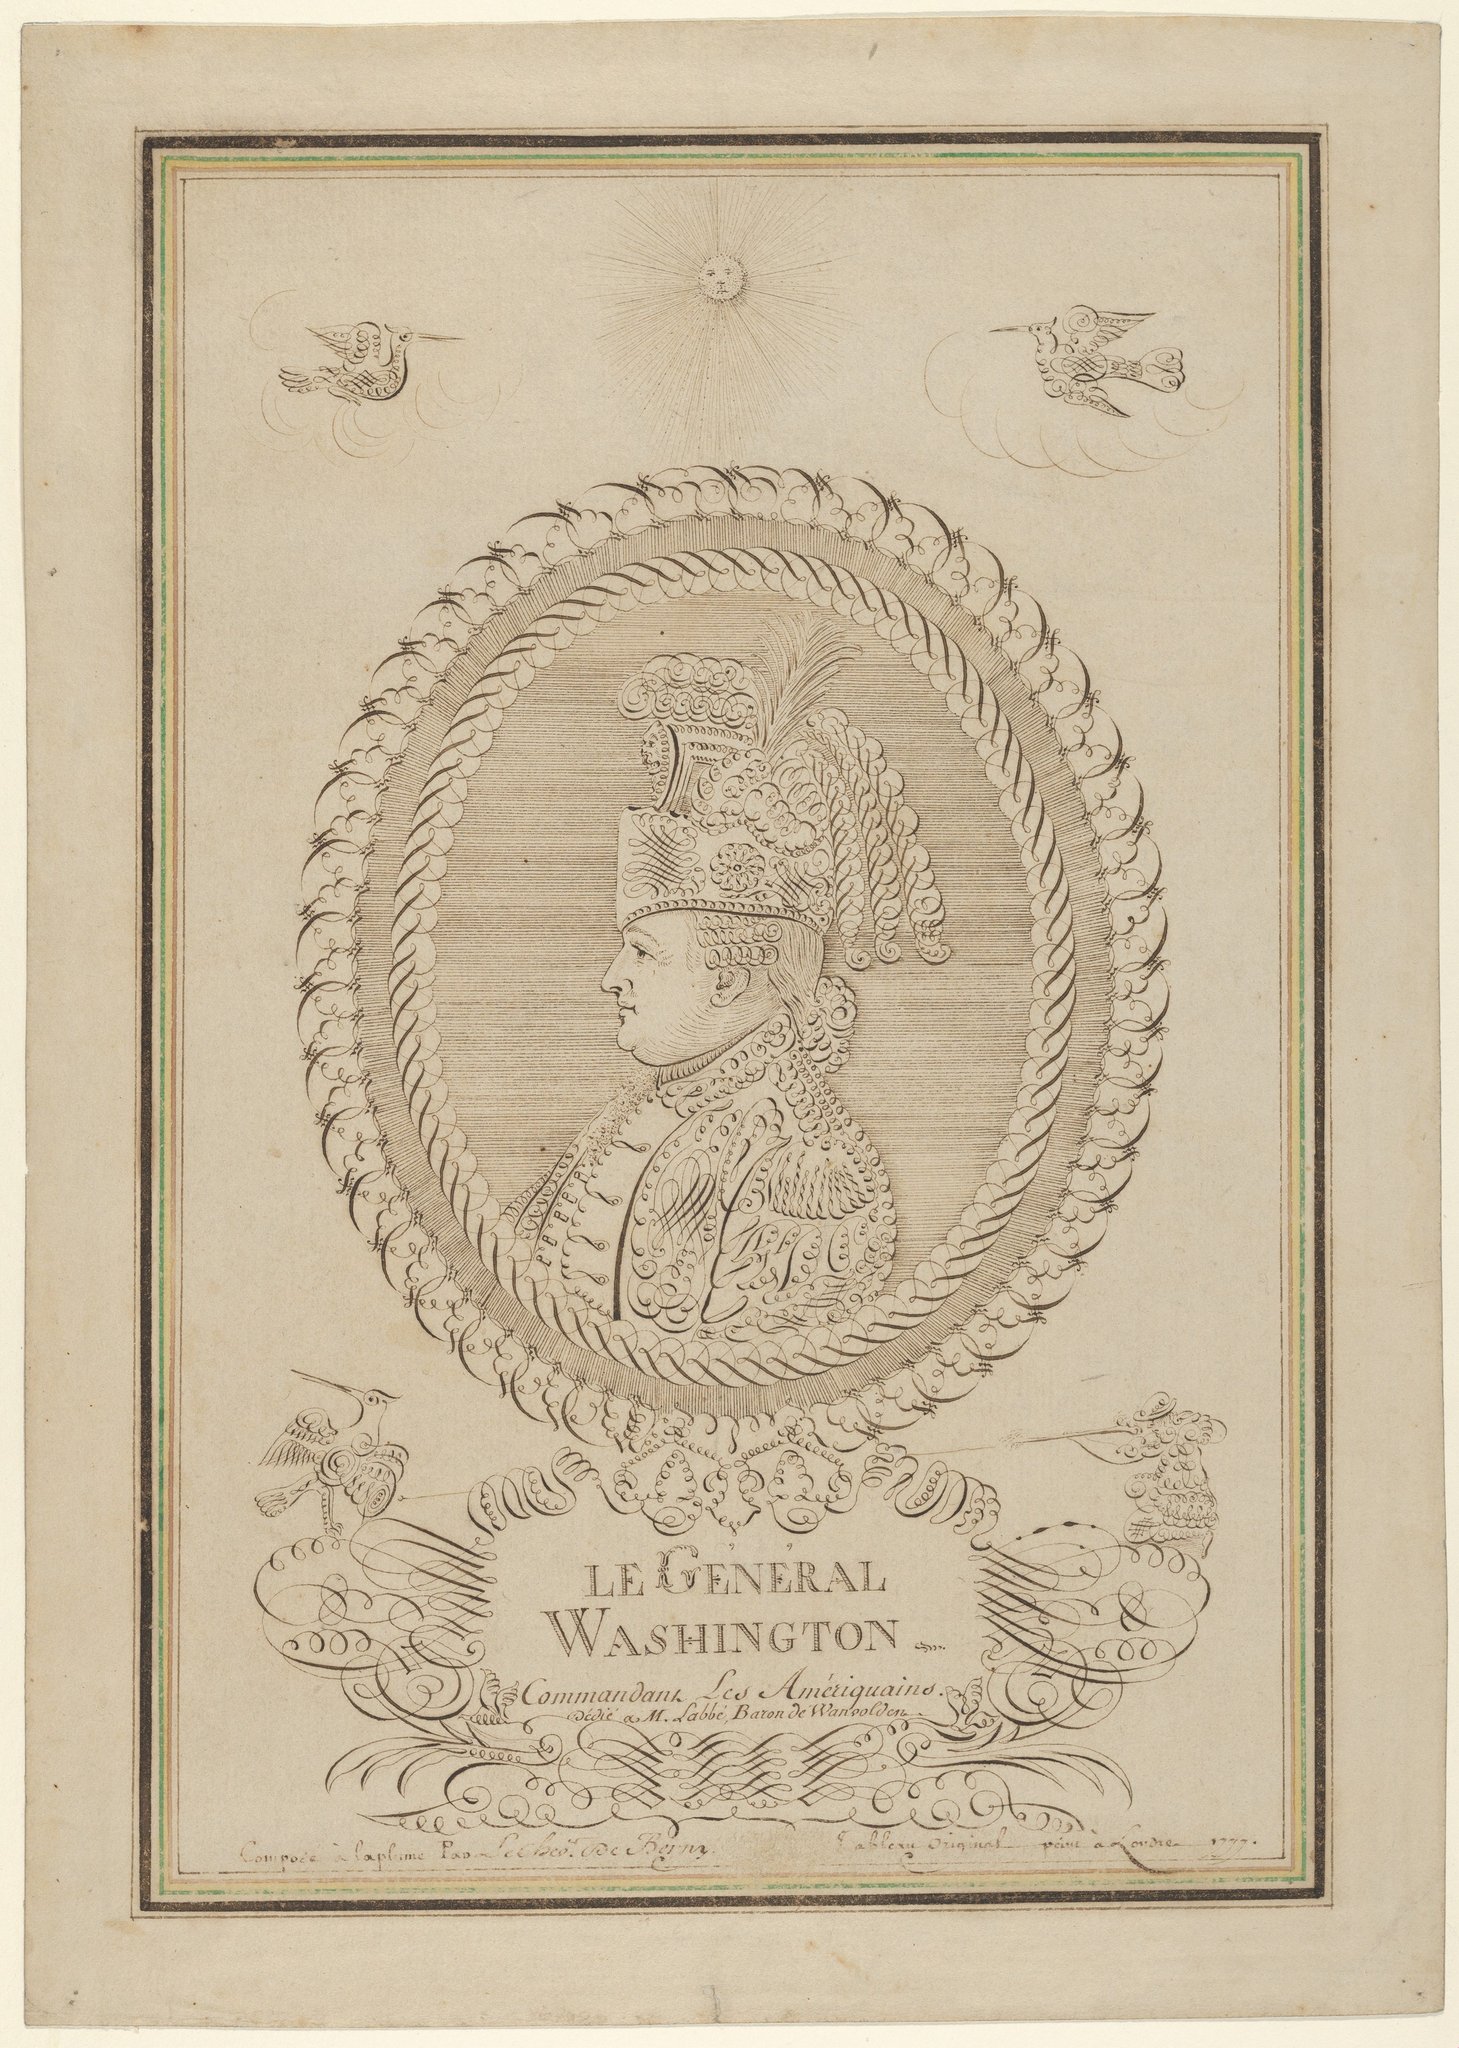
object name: drawing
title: Calligraphic Profile Portrait of George Washington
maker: pierre jean paul berny de nogen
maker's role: artist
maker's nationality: french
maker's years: 1722-1779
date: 1777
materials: ink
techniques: pen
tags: birds,george washington,profiles,sun